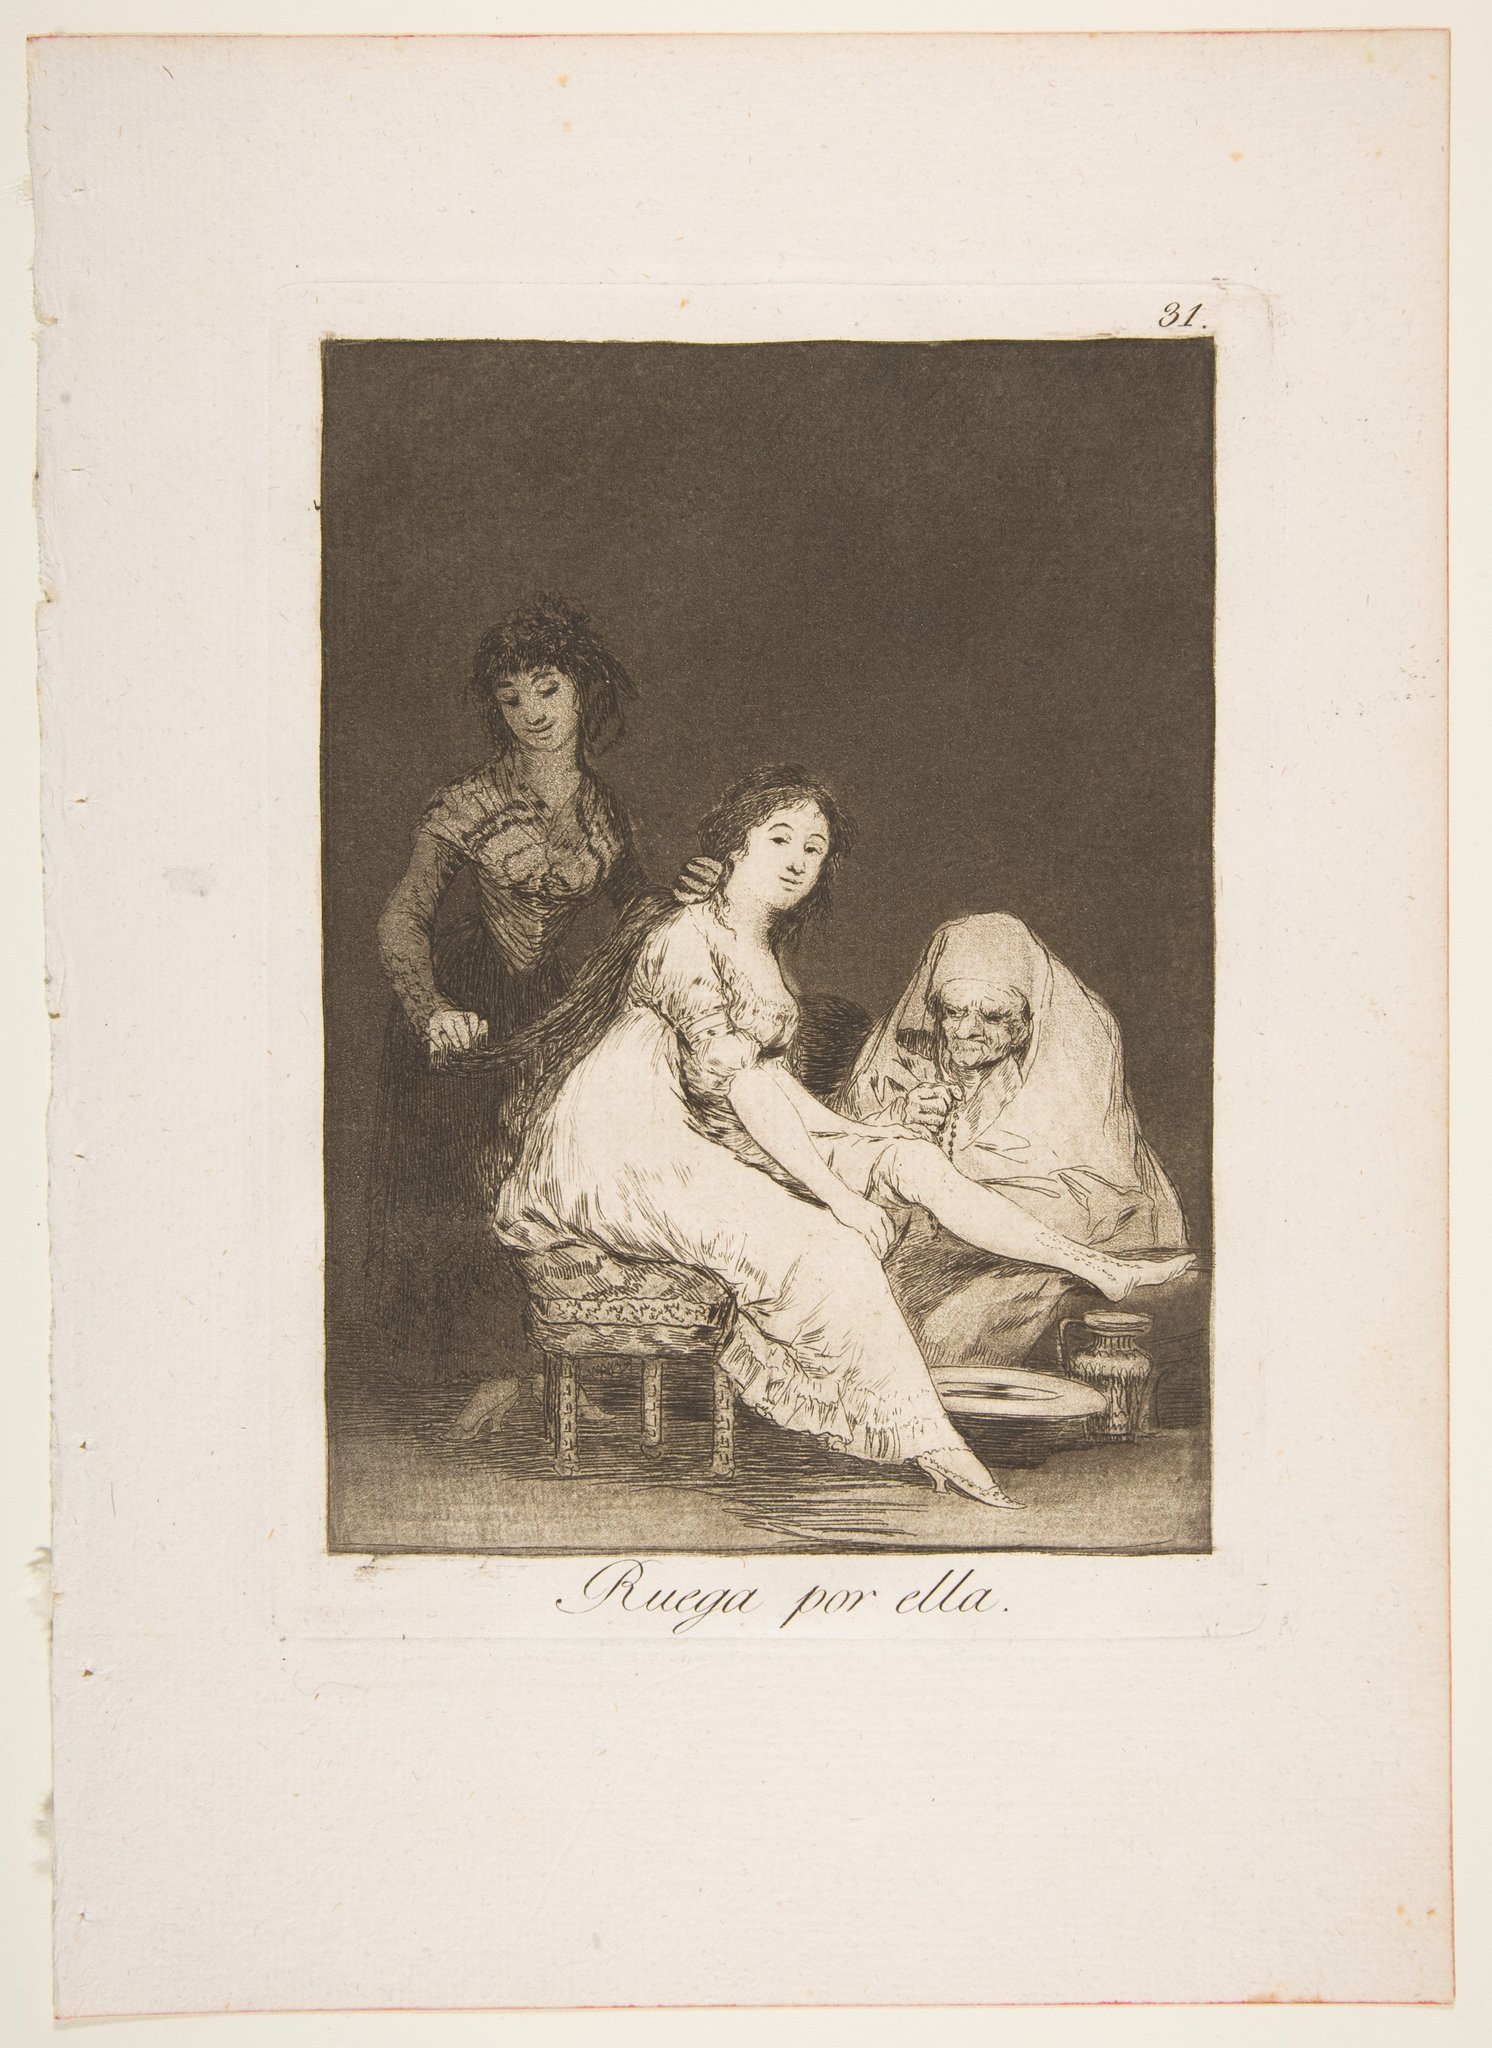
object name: print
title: Plate 31 from "Los Caprichos": She prays for her (Ruega por ella)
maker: goya (francisco de goya y lucientes)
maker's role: artist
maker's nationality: spanish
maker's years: 1746-1828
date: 1799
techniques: aquatint, engraving, burnishing, drypoint, etching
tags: women